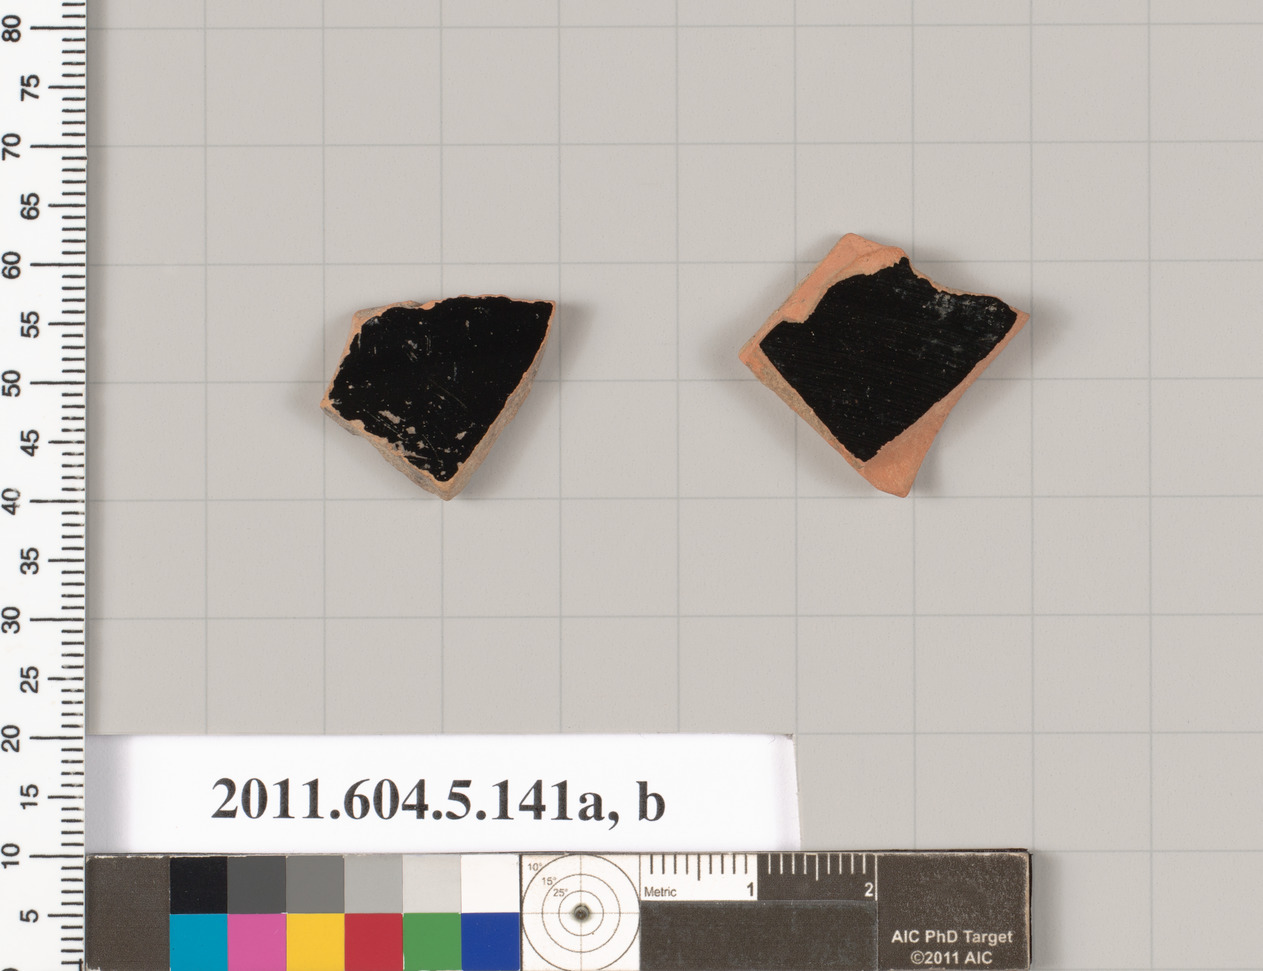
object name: kylix fragment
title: Terracotta fragments of kylikes (drinking cups)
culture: greek, attic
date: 600-401 BCE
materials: terracotta